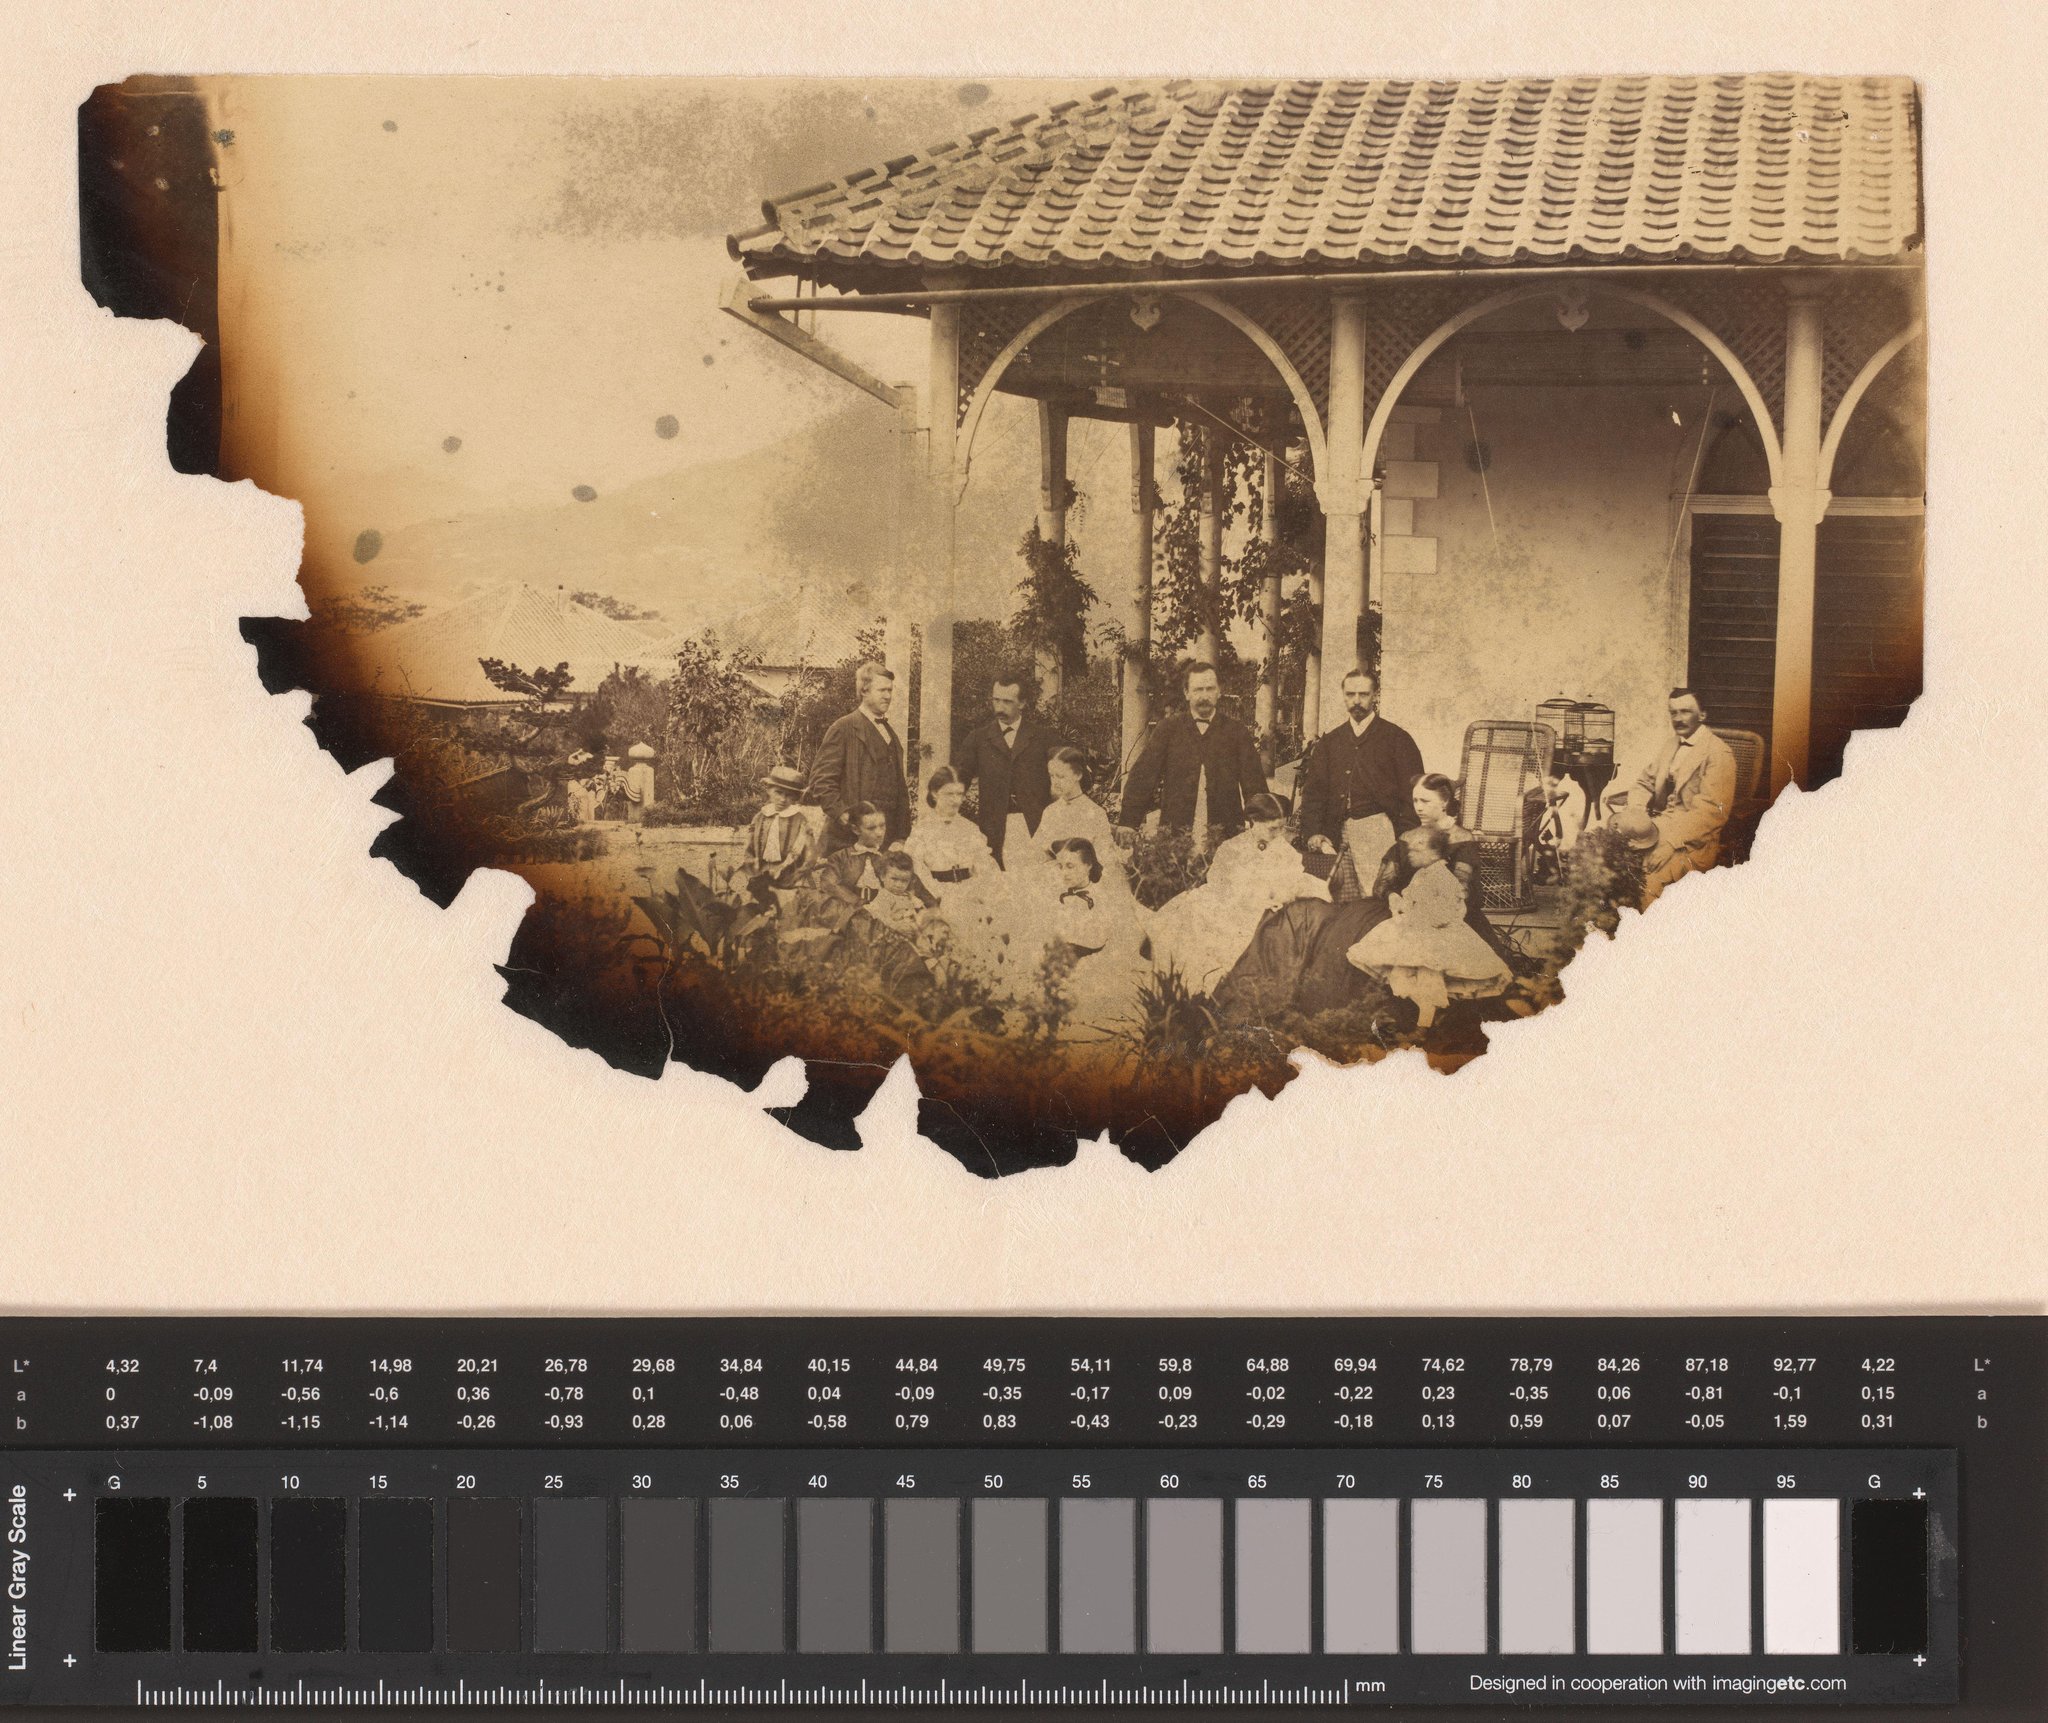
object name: photograph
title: Groepsportret bij hert huis van Thomas Glover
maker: antoon bauduin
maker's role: amateurfotograaf, hoogleraar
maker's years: 1820-1885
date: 1862-1866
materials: paper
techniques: albumen print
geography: japan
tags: anonymous historical persons portrayed in a group, in a group-portrait, japan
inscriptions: number: ‘35’